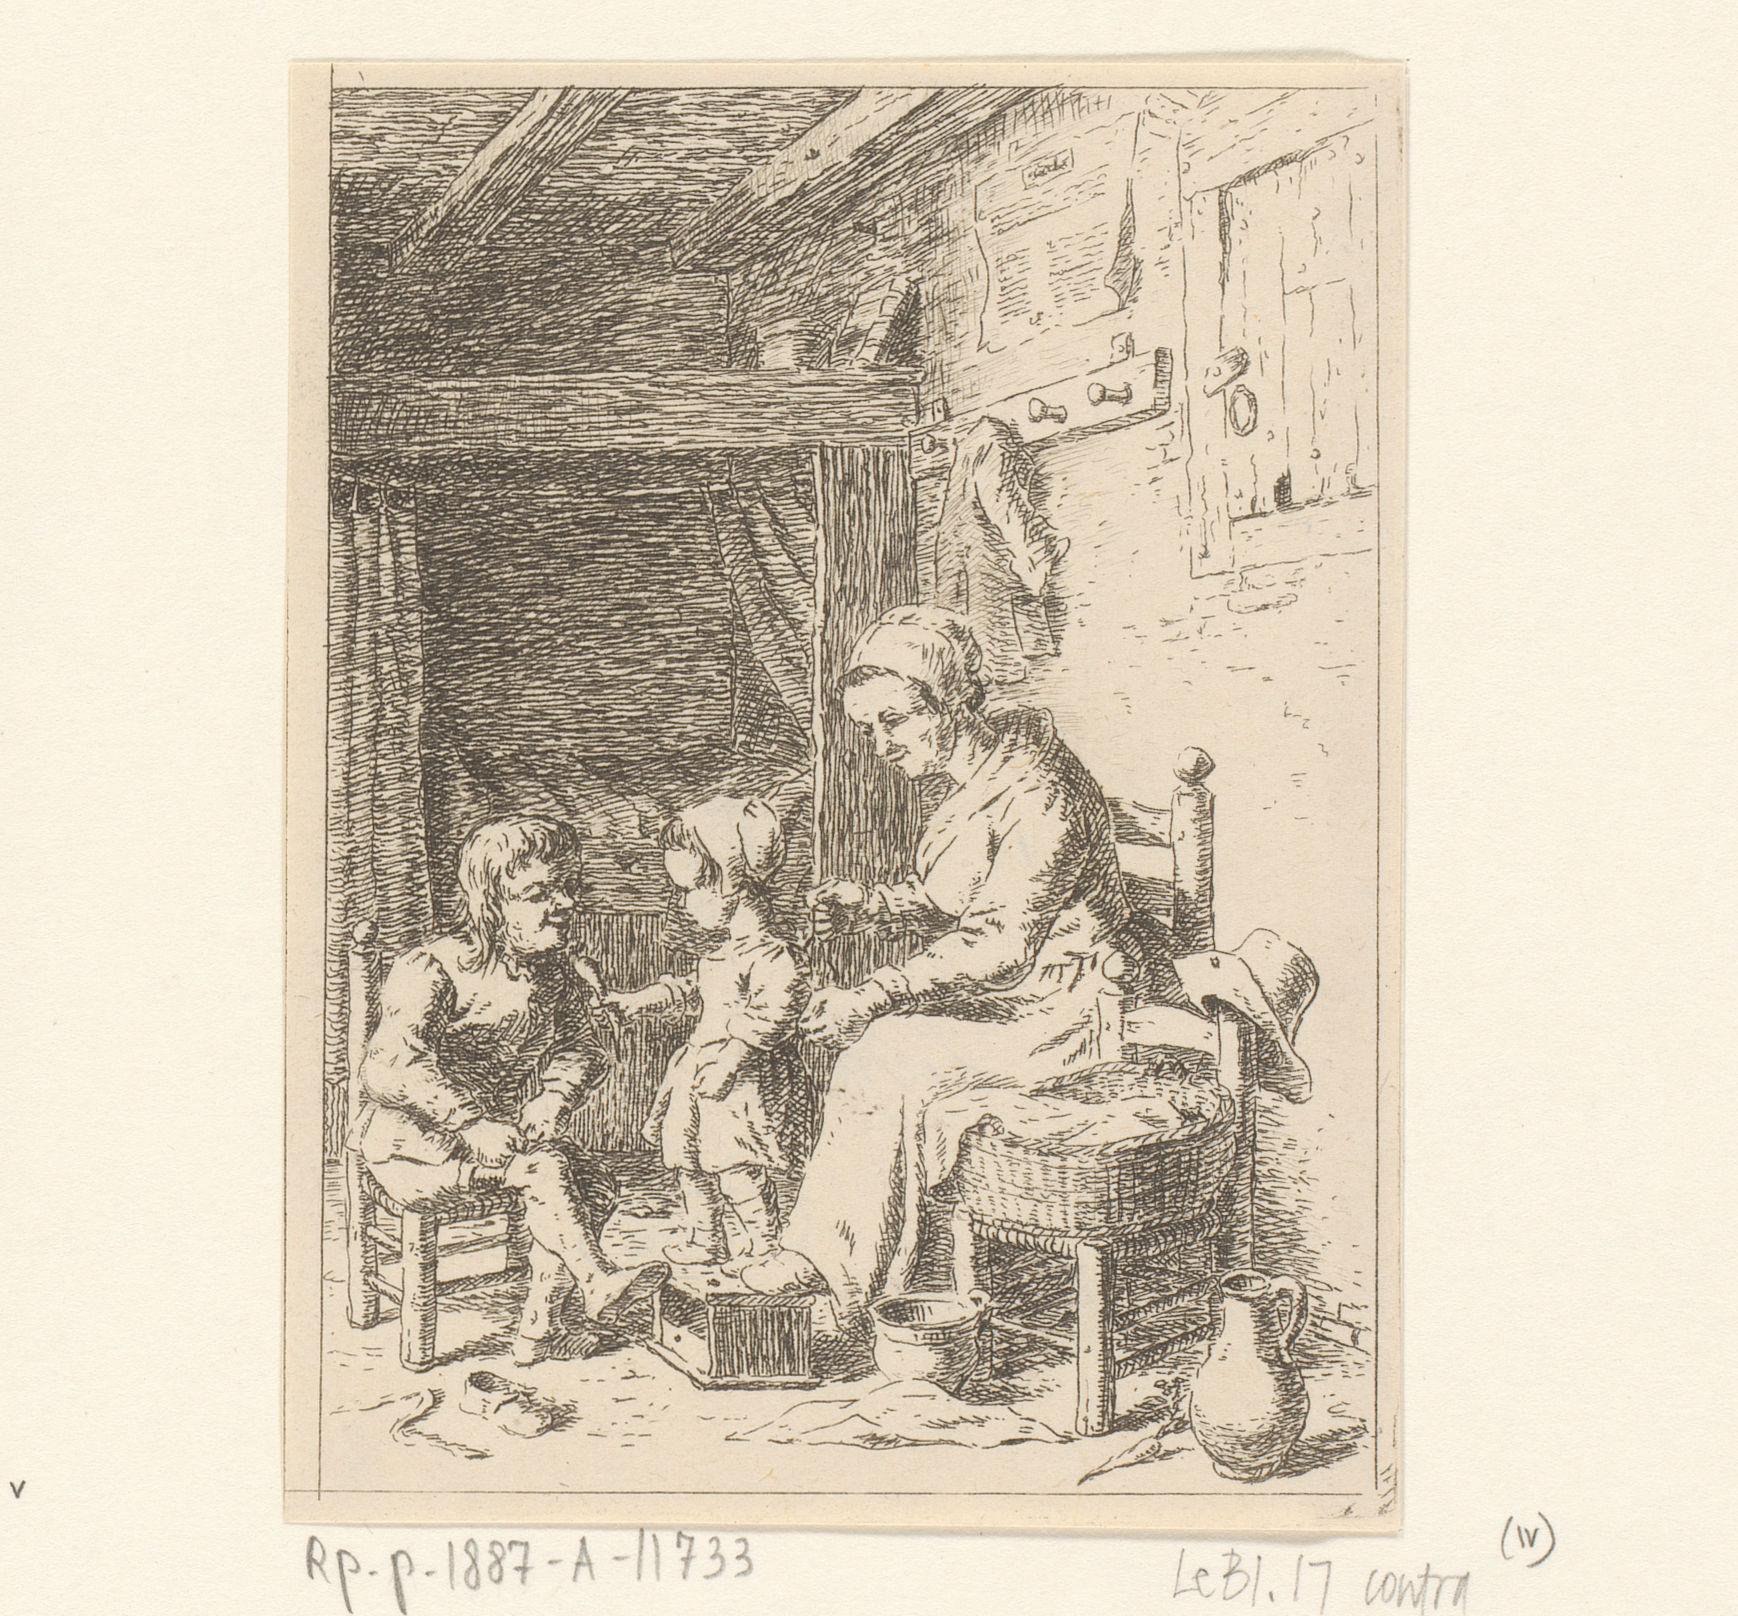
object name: print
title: Ochtendtoilet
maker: christina chalon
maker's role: draughtsman, print maker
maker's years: 1748-1808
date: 1758-1808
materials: paper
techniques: printmaking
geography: leiden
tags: dressing oneself, getting dressed, mother and child(ren), woman and child(ren) (family group) (with number of children), dressing oneself, getting dressed - aa - female human figure, bedroom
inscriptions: collector's mark: Lugt 2228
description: Interieur van een slaapkamer. Een moeder helpt haar kinderen bij het ochtendtoilet. Ze rijgt het jurkje van haar dochter van achteren dicht. Haar zoontje trekt ondertussen zijn kousen aan.